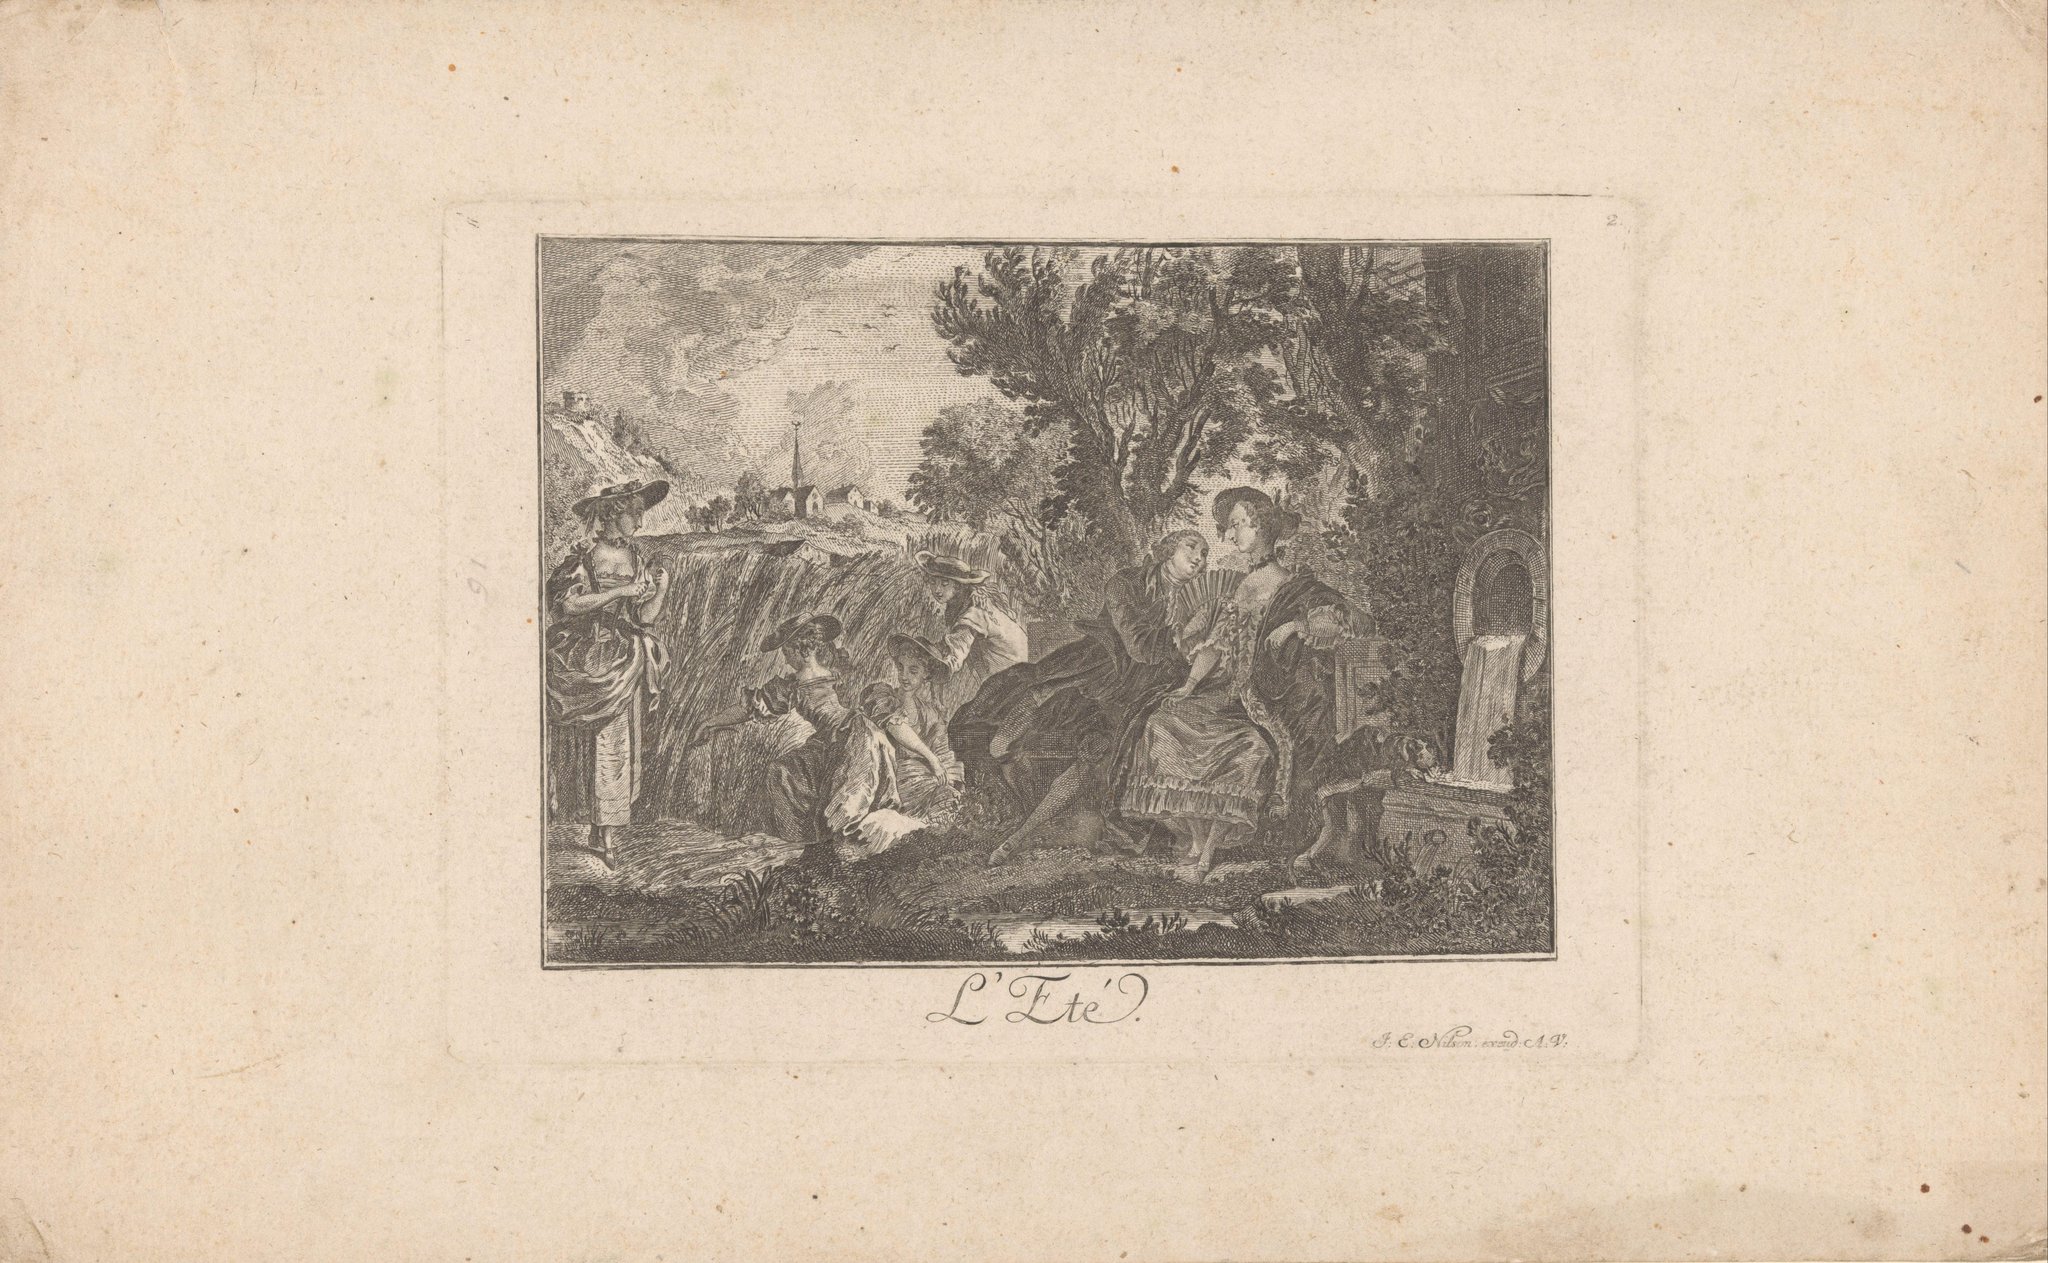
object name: ornament print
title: De vier seizoenen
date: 1731-1788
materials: paper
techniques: etching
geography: augsburg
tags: summer ~ human activities (the four seasons of the year), reaping, picking, mowing ~ harvest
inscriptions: collector's mark: Lugt 2228, collector's mark: Lugt 2760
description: Menselijke bezigheden tijdens de zomer. Rechts zitten een man en een vrouw op een bank in de schaduw. Rechts drinkt een hond uit een fontein. Links snijden vier vrouwen met sikkels graan af.